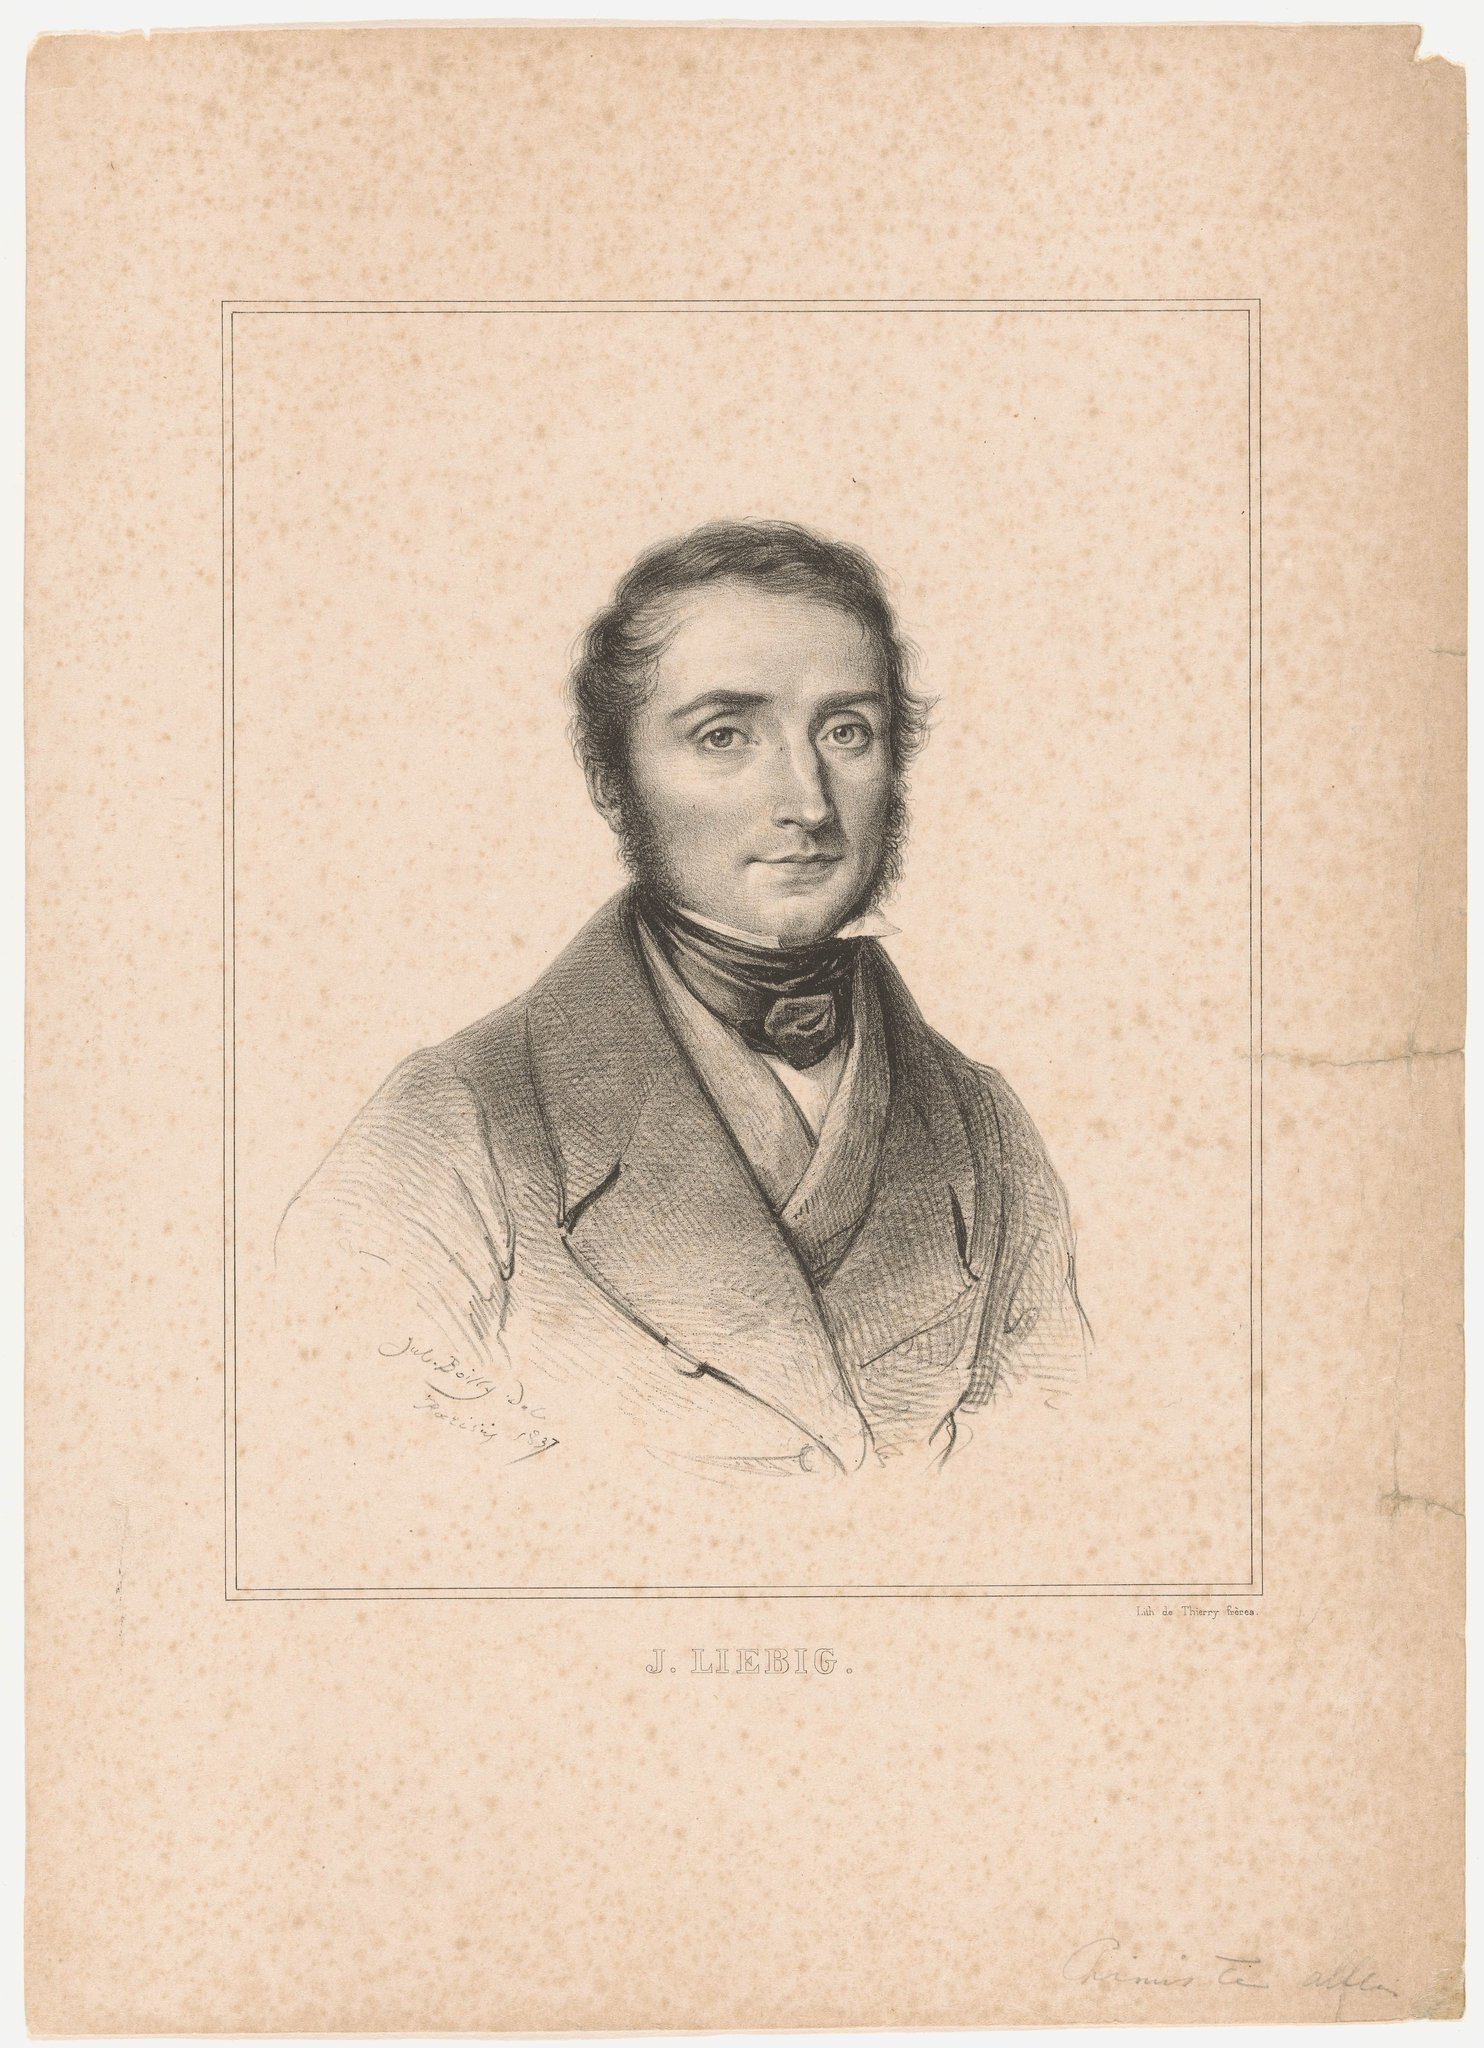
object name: print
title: Portret van de scheikundige Justus von Liebig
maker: julien-léopold boilly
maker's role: print maker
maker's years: 1796-1874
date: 1837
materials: paper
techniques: lithograph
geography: paris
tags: historical persons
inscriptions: collector's mark: Lugt 2228a